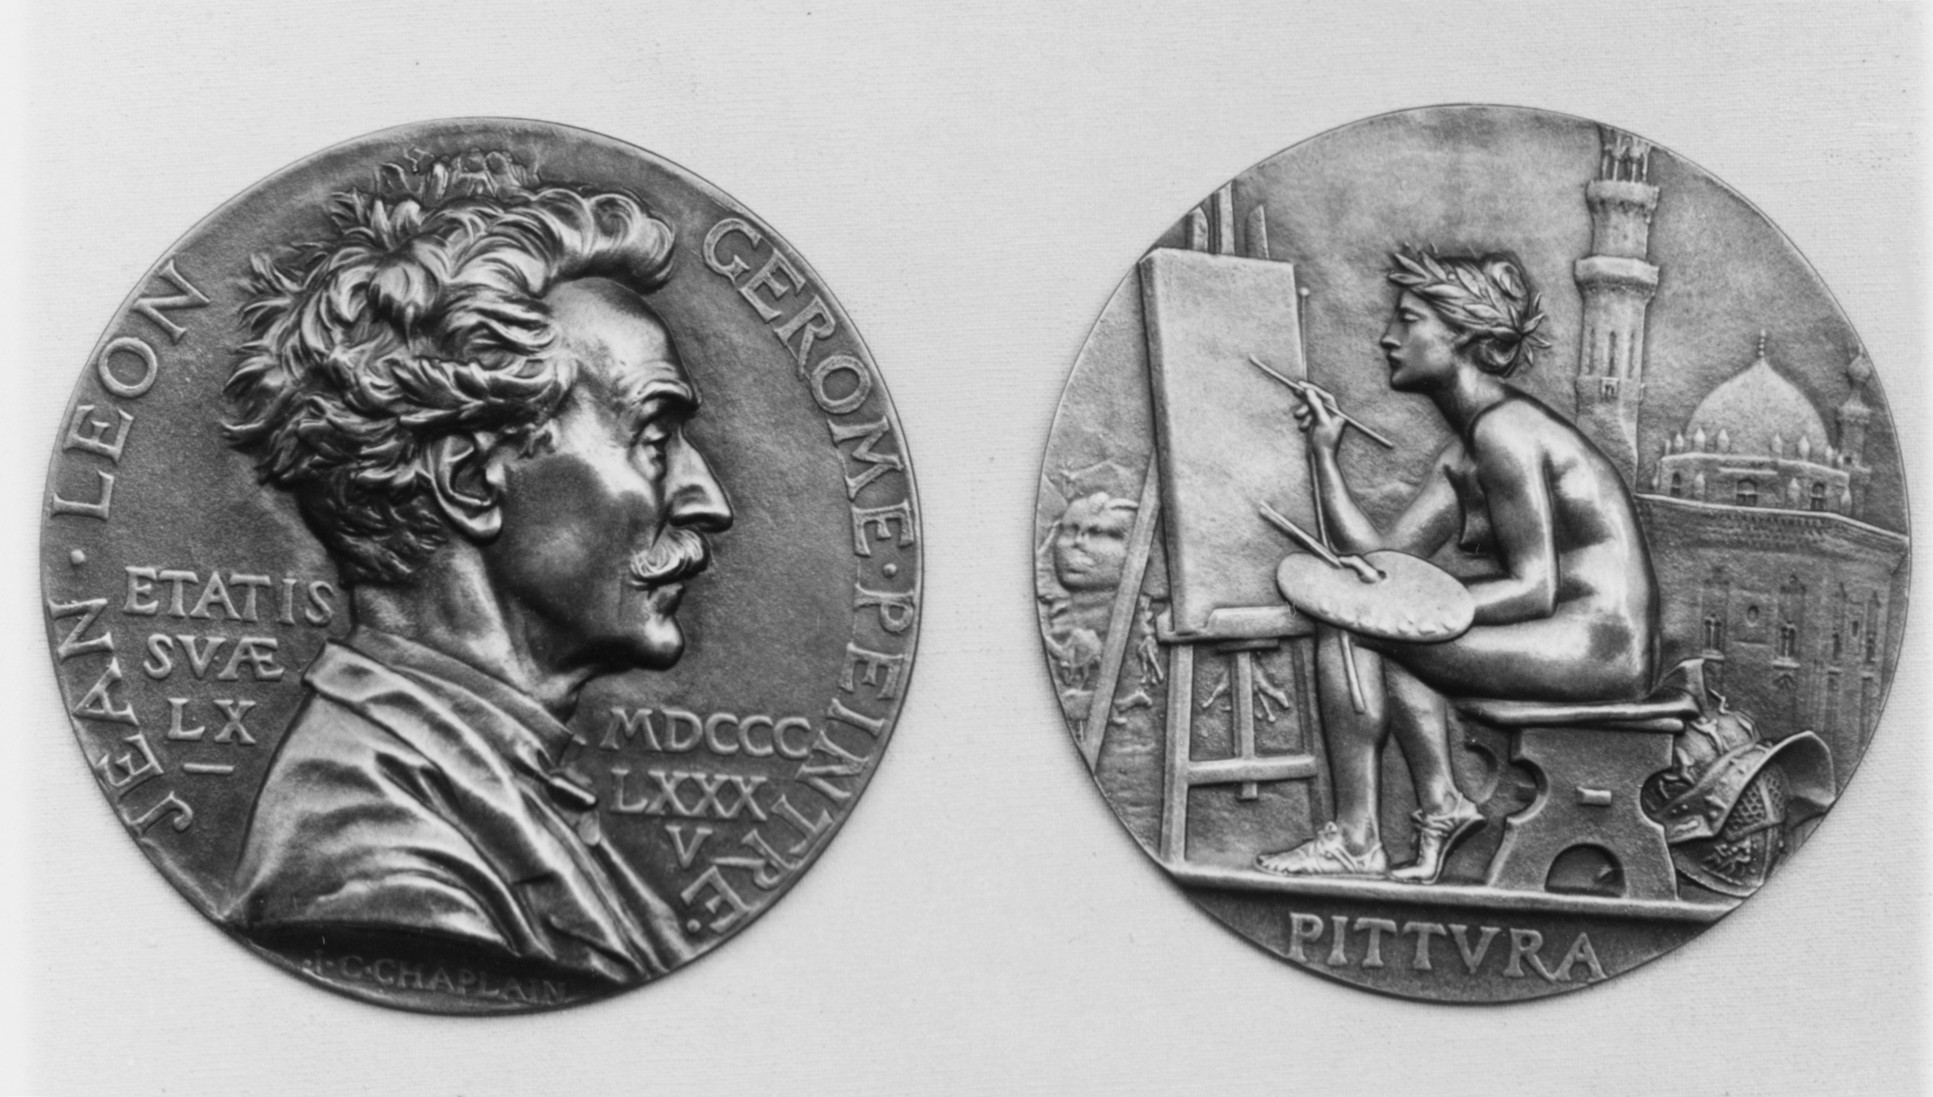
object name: medallion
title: Jean Léon Gérôme (1824–1904), French Painter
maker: jules-clément chaplain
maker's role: artist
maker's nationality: french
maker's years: 1839-1909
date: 1885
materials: bronze, patina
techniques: casting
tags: painting,men,profiles,female nudes